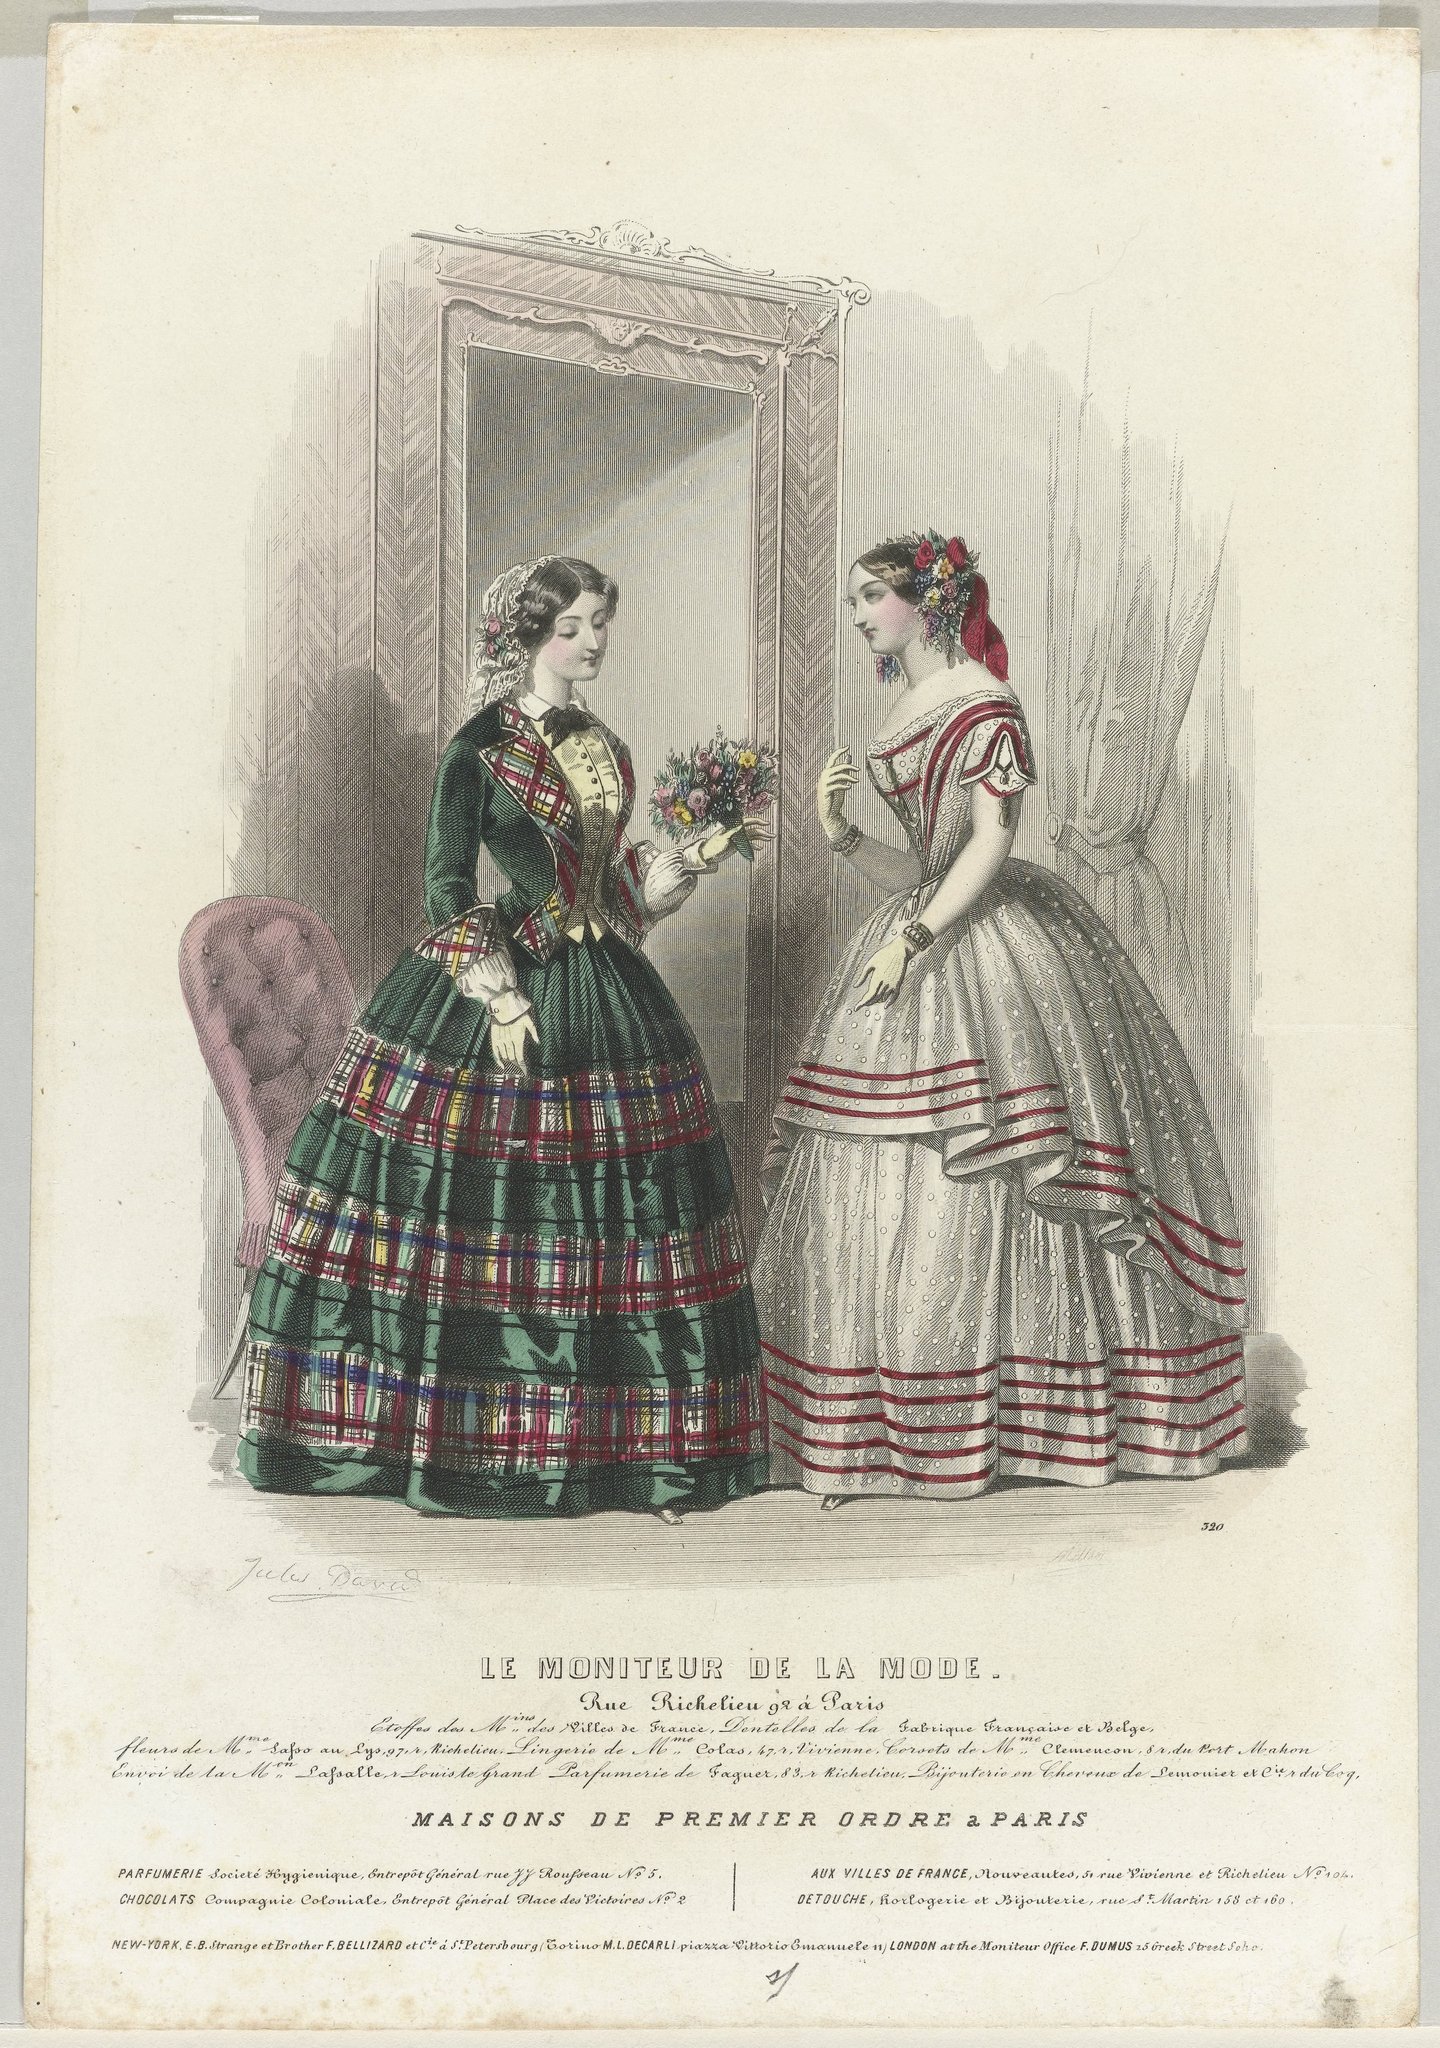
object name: fashion print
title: Le Moniteur de la Mode, 1852, No. 320 : Etoffes des M.ins. des villes de France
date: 1852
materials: paper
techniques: hand coloring, engraving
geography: new york city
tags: clothing for the upper part of the body (+ women's clothes), cut flowers; nosegay, bunch of flowers, lace (+ women's clothes), head-gear (+ women's clothes), fashion plates, shoes, sandals (+ women's clothes), skirt (+ women's clothes), gloves, mittens, etc. (+ women's clothes), neck-gear ~ clothing (+ women's clothes), bracelet, wristlet (+ women's clothes)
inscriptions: address: ‘New-York. E.B. Strange et Brother. F. Bellizard et C.ie à S.t Pétersbourg. / Torino M.L. Decarli piazza Vittorio Emanuele 11 / London at the Moniteur Office. F. Dumus 15 Greek Street Soho.’, title: ‘Le Moniteur de la Mode.’, caption: ‘Etoffes des M.ins des Villes de Frances, Dentelles de la Fabrique Française et Belge, fleurs de M"me Sasso au Lys, 97, r, Richelieu, Lingerie de M"me Colas, 47, r, Vivienne, Corsets de M"me Clemencon, 8 r, du Port Mahon Envoi de la M"on Lassalle, r Louis le Grand Parfumerie de Faguet, 83, r. Richelieu, Bijouterie en Cheveux de Lemonier et C.ie r du Coq.’, address: ‘Rue Richelieu 92 à Paris’, caption: ‘Maisons de premier ordre a Paris / Parfumerie Societé Hygienique, Entrepôt Général rue JJ Rousseau No.5. Chocolats Compagnie Coloniale, Entrepôt Général Place des Victoires No. 2 / Aux Villes de France, Nouveautes, 51 rue Vivienne et Richelieu No. 104. Detouche, horlogerie et Bijouterie, rue S.t Martin 158 et 160.’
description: Twee vrouwen in een interieur, van wie één met een boeket bloemen in de hand. Onder de voorstelling enkele regels reclametekst voor verschillende producten. Prent uit het modetijdschrift Le Moniteur de la mode (1843-1913).